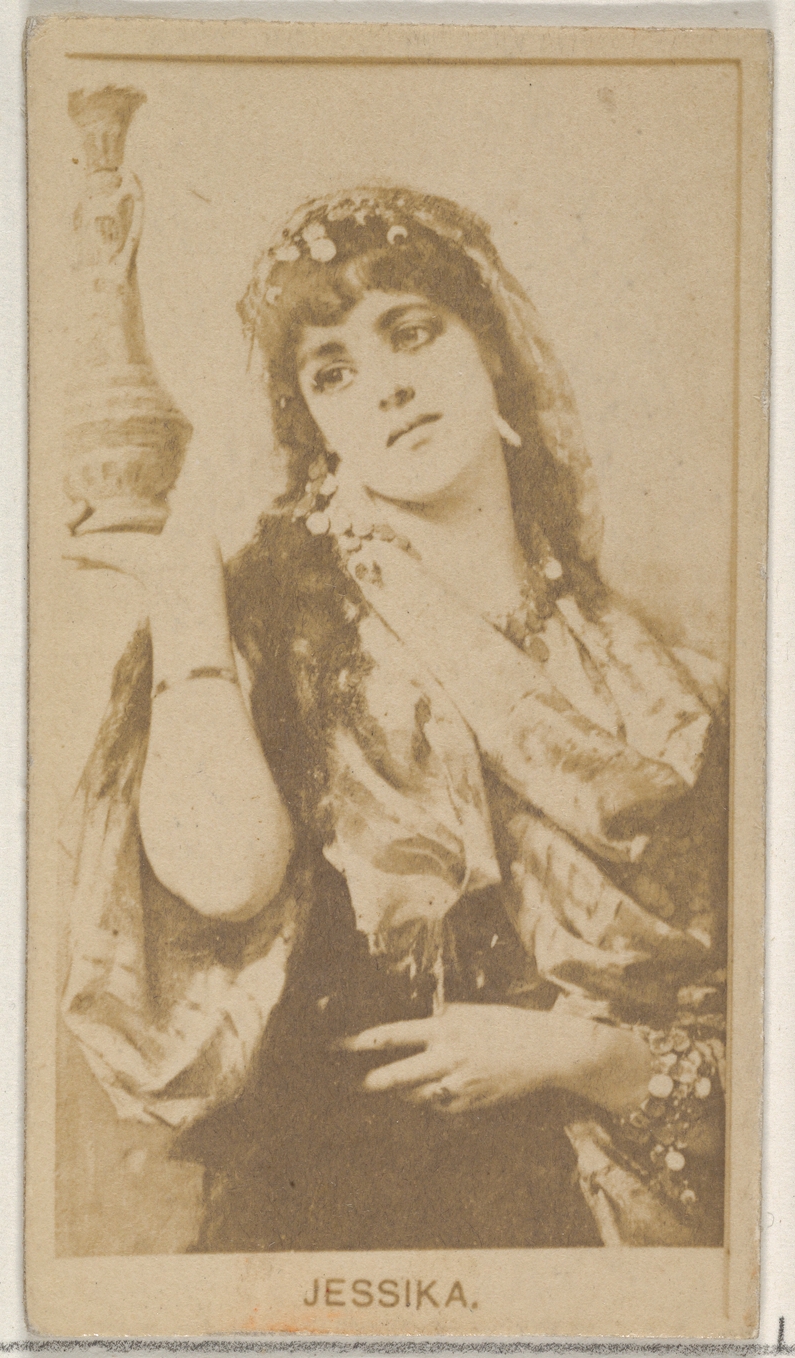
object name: photograph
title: Jessika, from the Actors and Actresses series (N45, Type 8) for Virginia Brights Cigarettes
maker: allen & ginter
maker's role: publisher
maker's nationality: american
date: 1888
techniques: albumen silver print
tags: portraits,women,actresses